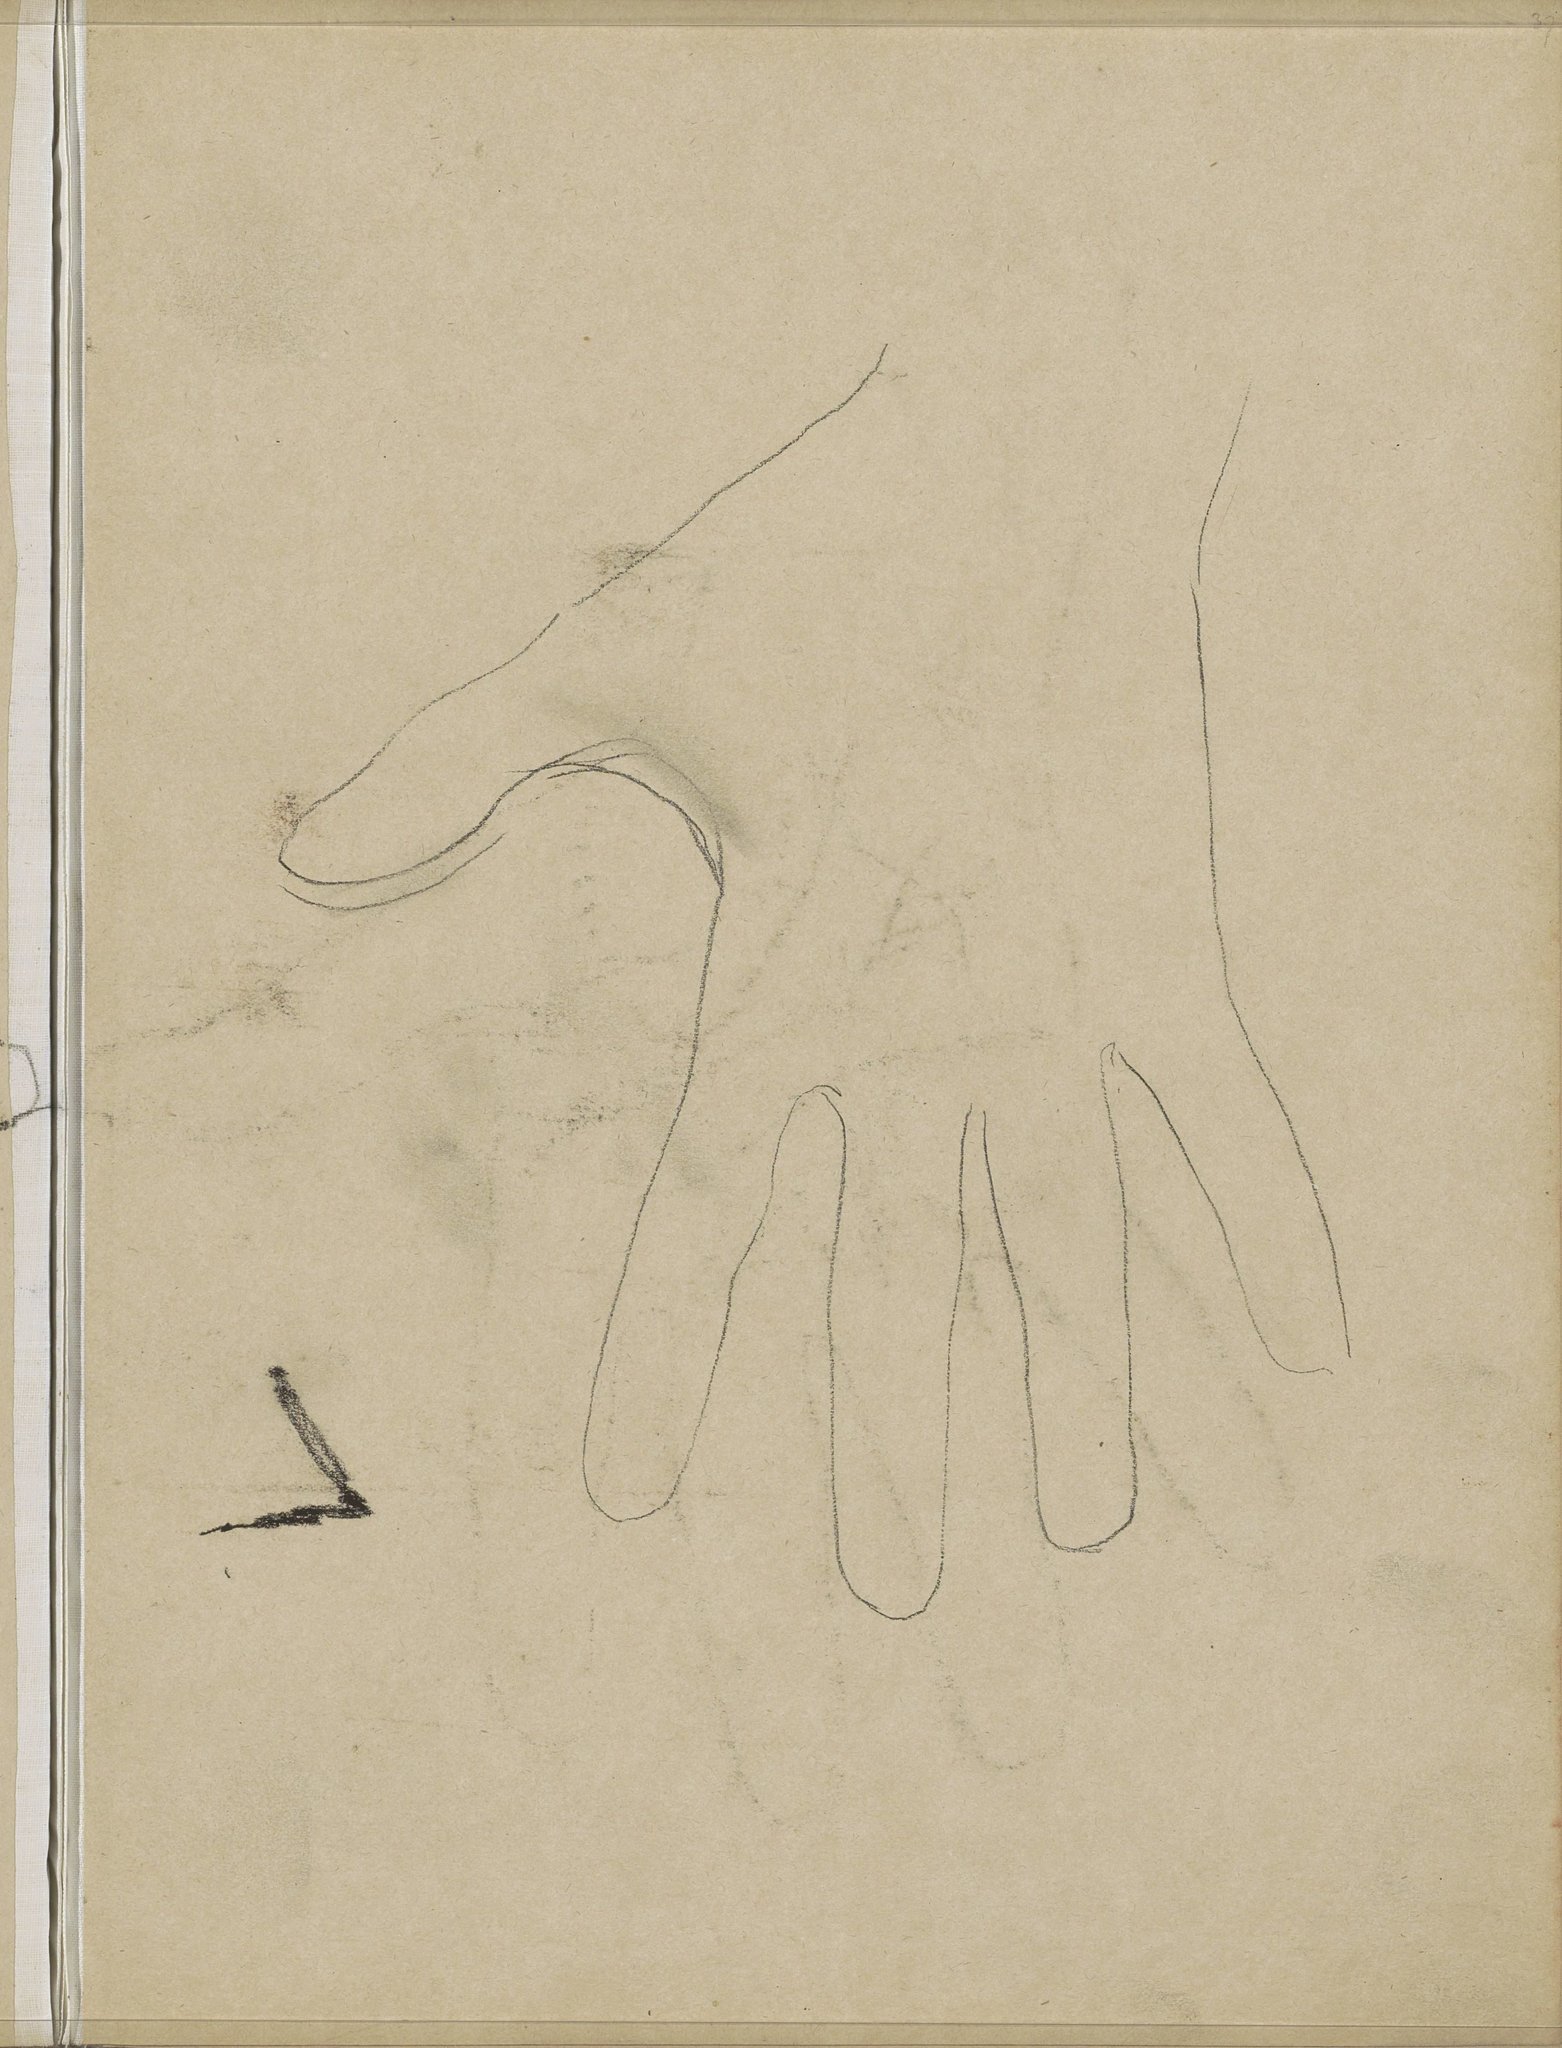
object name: sketchbook leaf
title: Hand met gespreide vingers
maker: willem witsen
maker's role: draughtsman, painter, print maker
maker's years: 1860-1923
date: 1874-1923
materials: chalk, paper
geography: ewijkshoeve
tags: hand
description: Pagina 37 uit een schetsboek met 72 bladen.